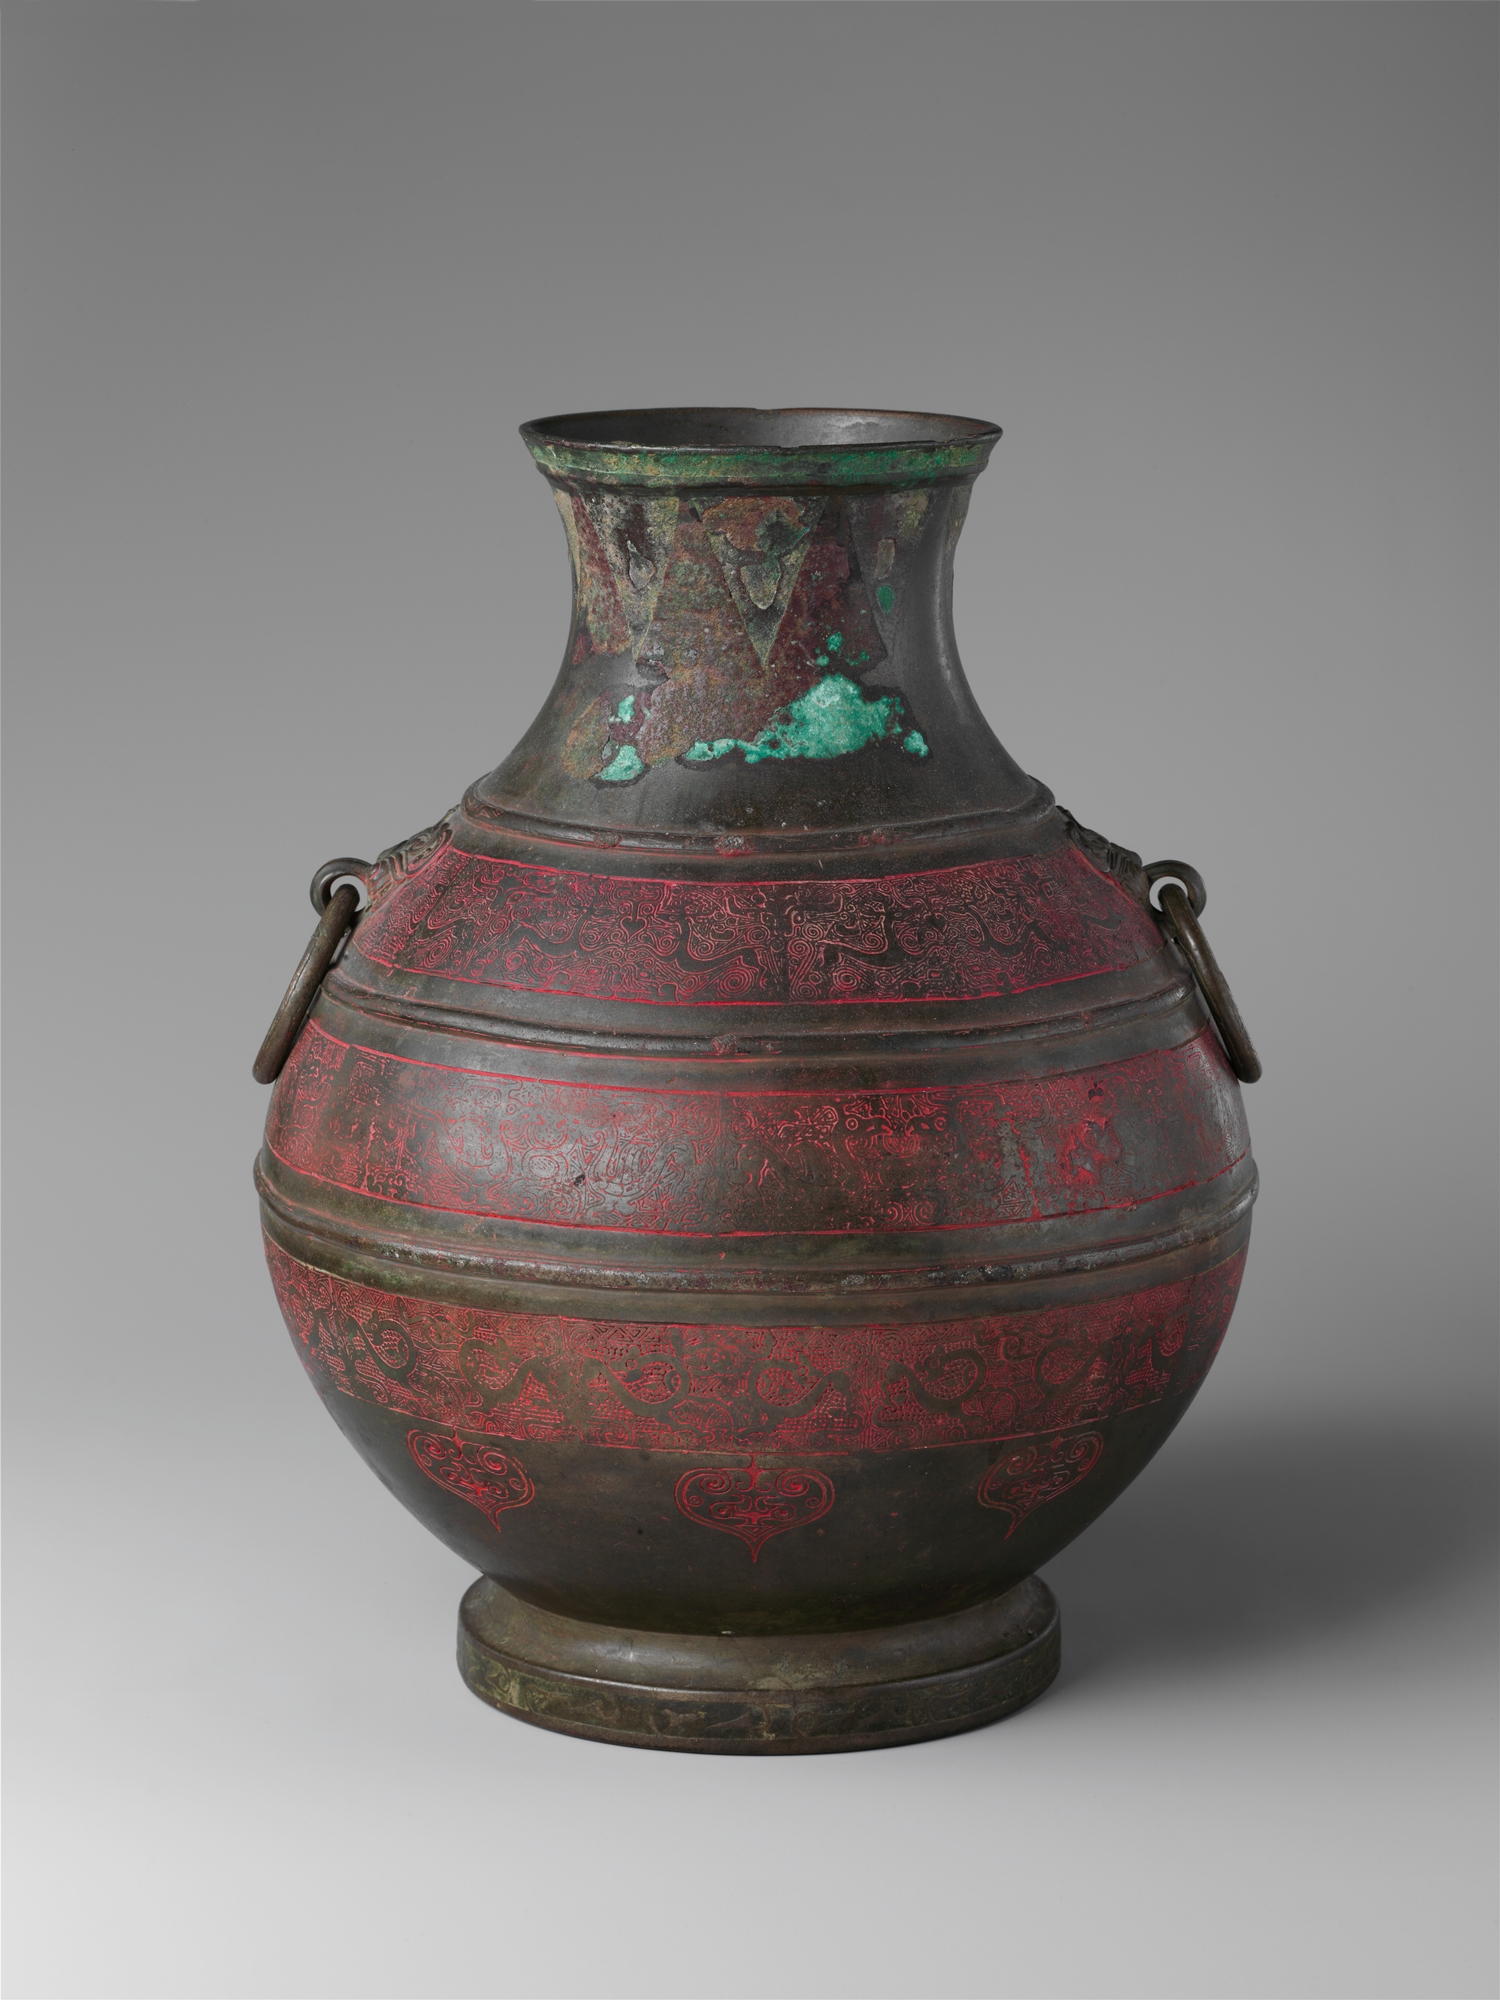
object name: wine container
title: Ritual wine container (hu)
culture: chinese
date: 300-101 BCE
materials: bronze